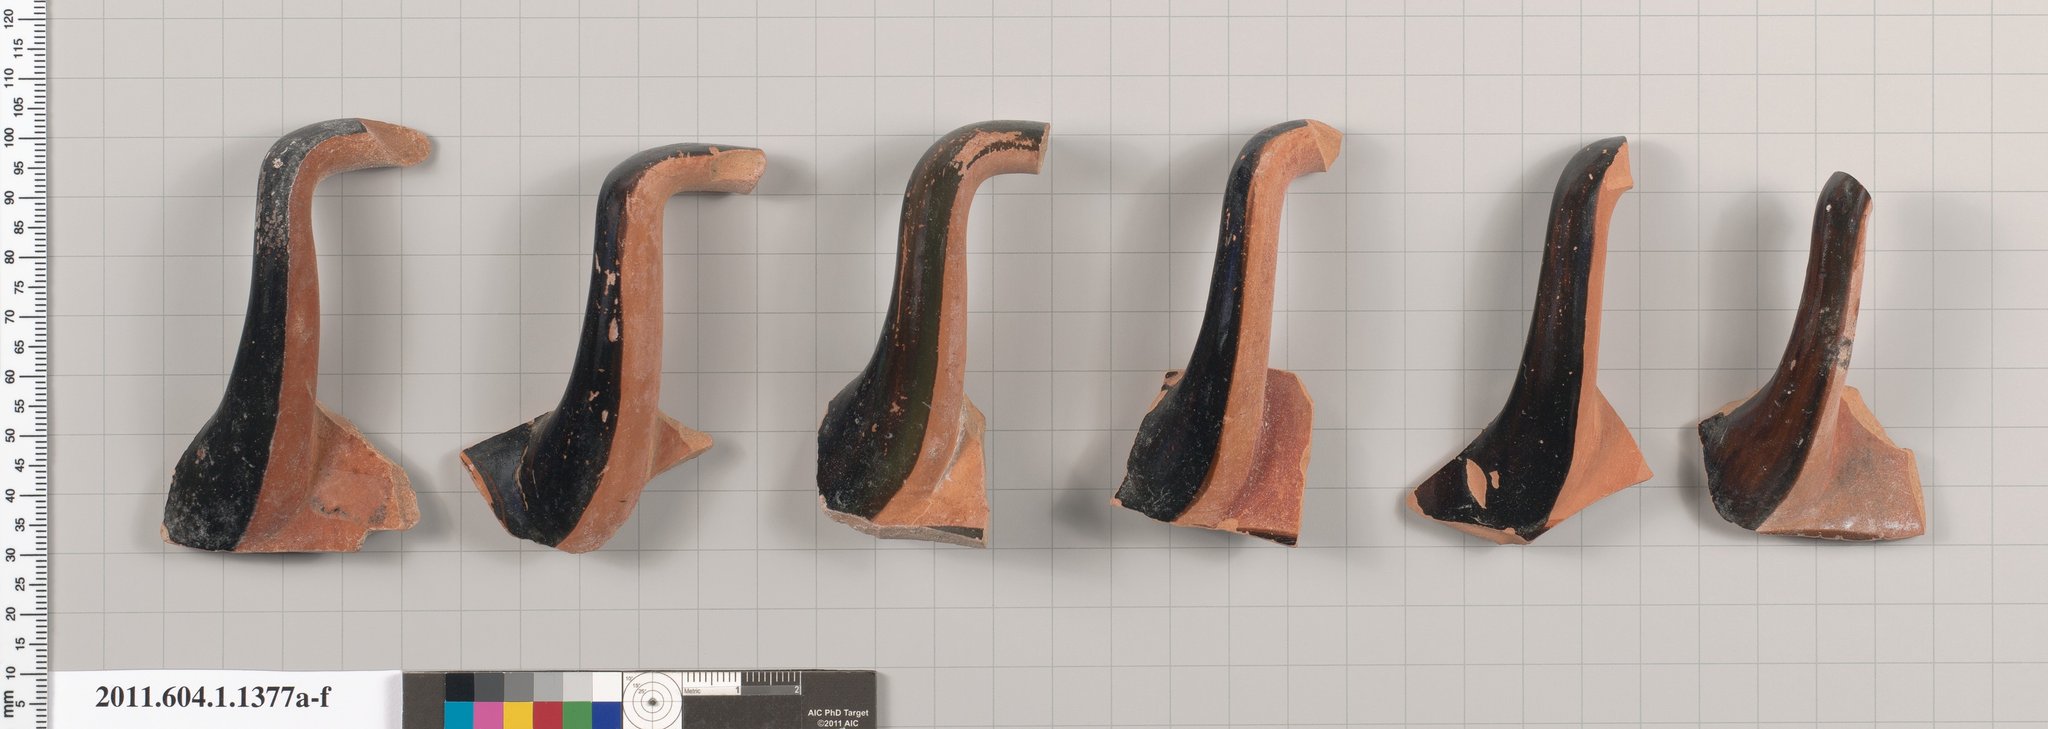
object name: kylix fragment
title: Terracotta fragments of kylikes (drinking cups)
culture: greek, attic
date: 500-401 BCE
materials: terracotta